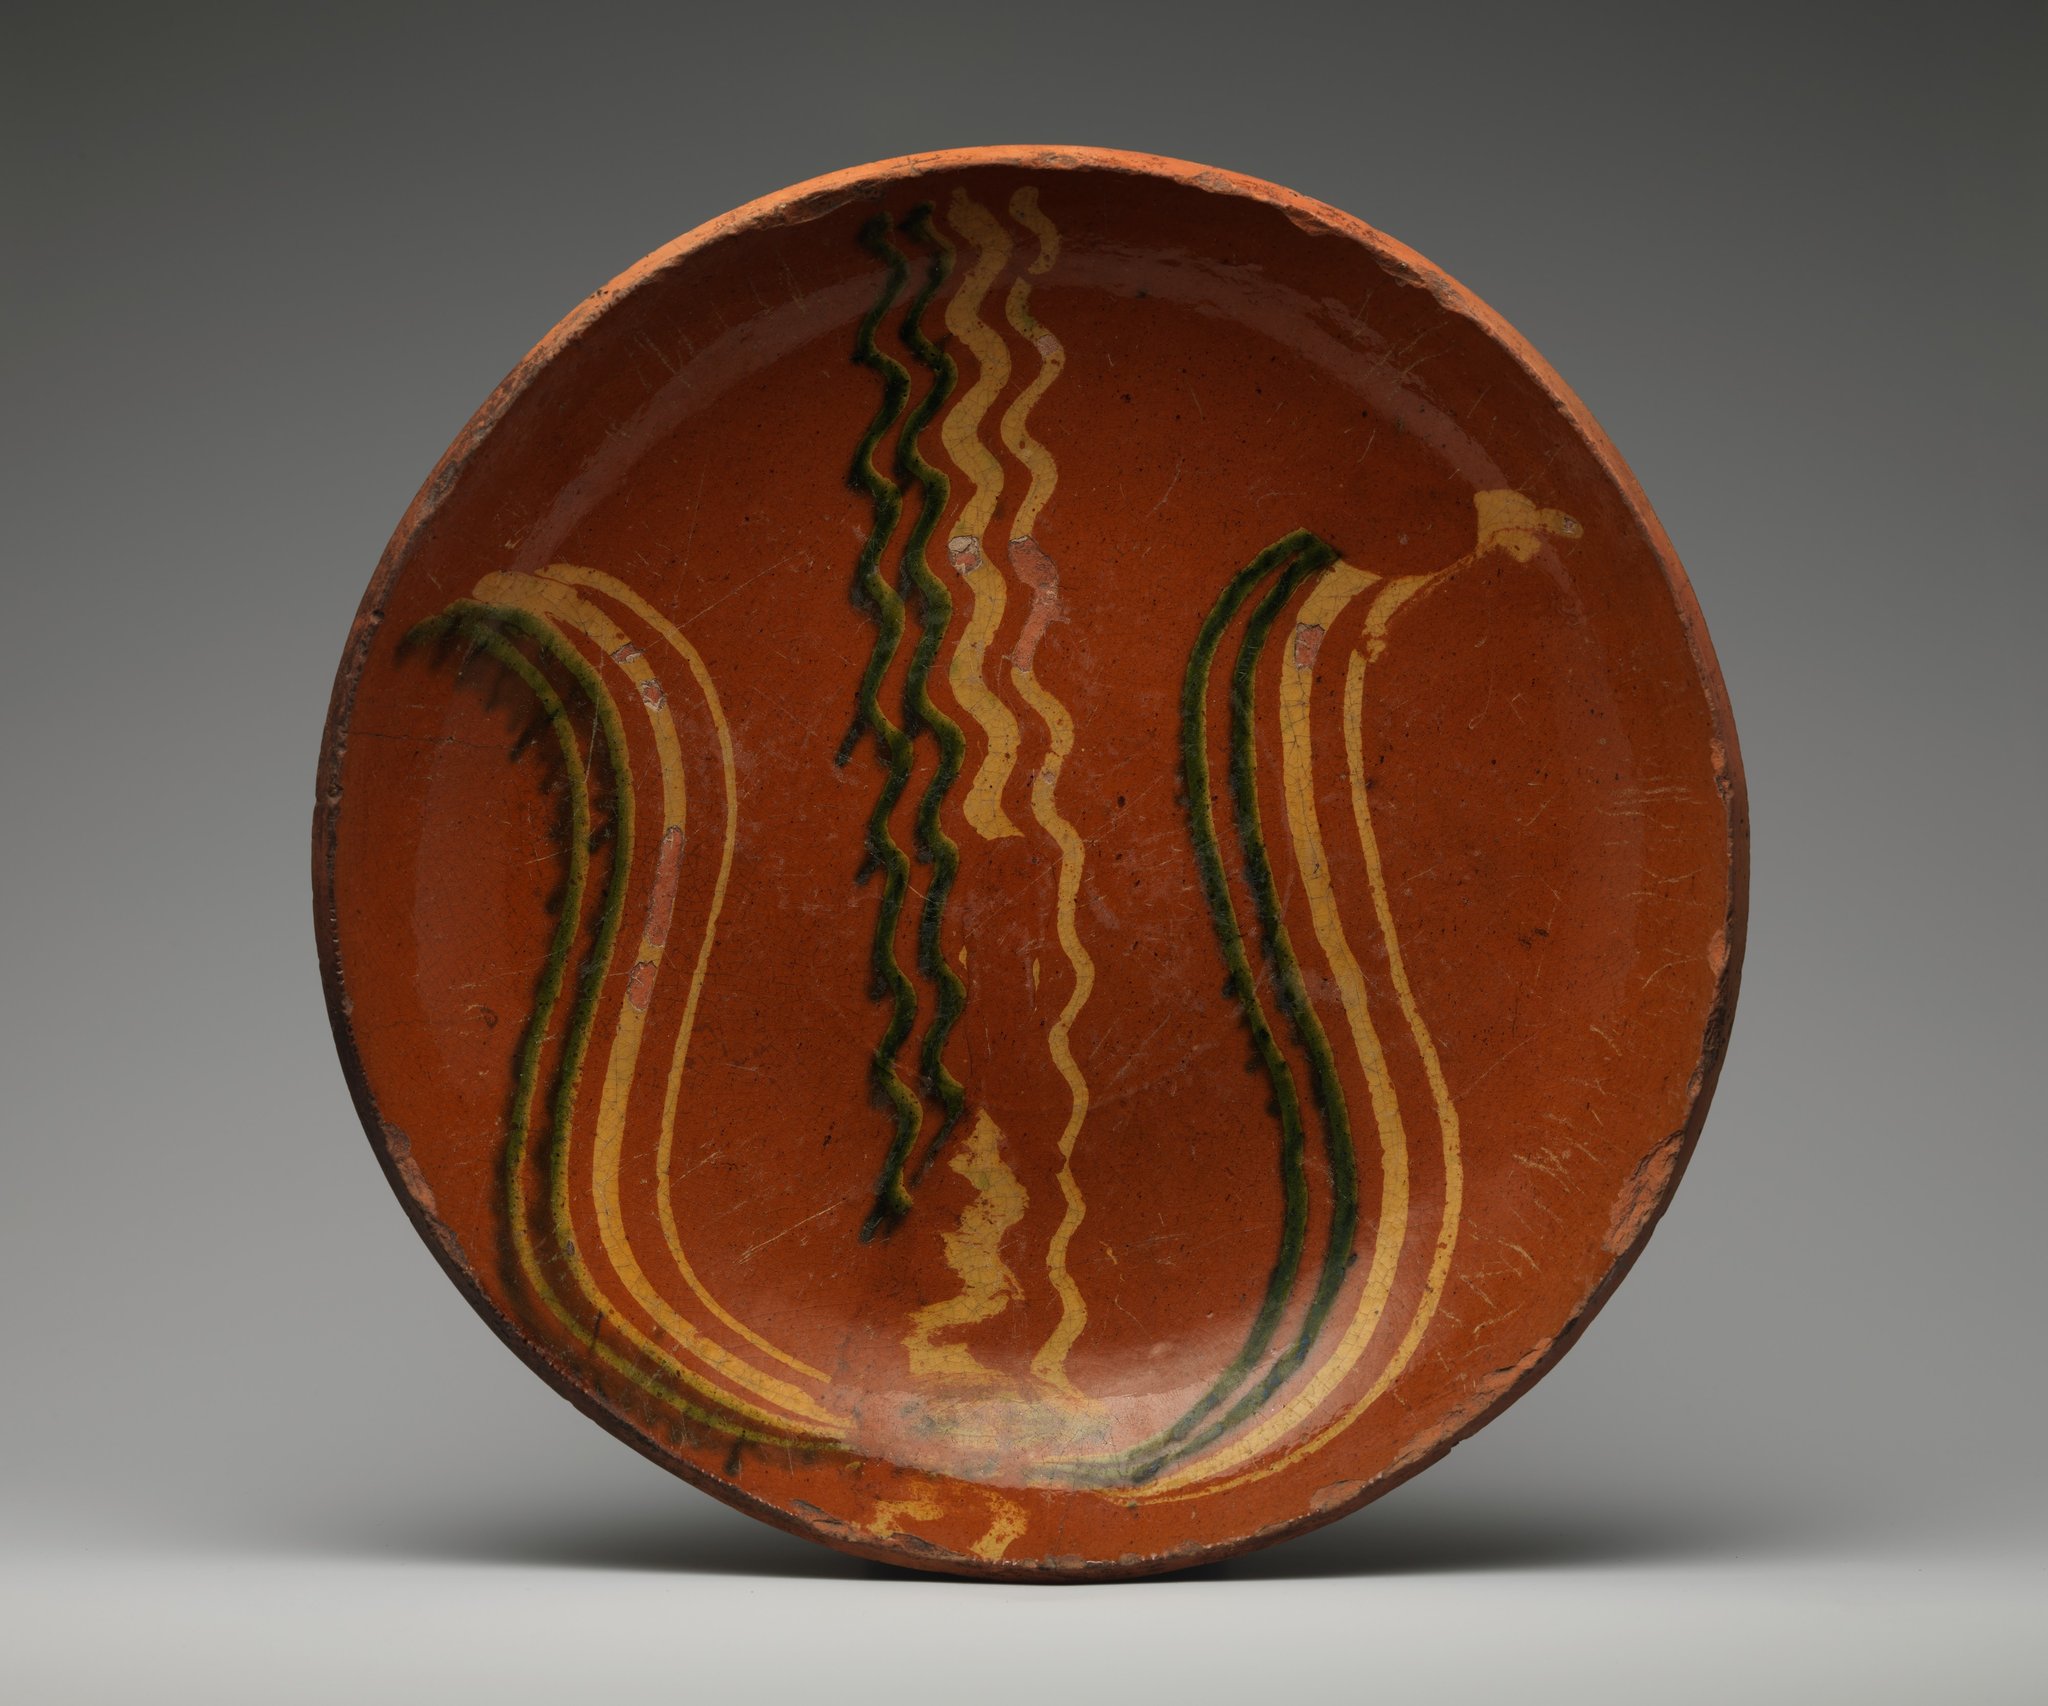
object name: plate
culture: american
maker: daniel dry , active ca. 1820-80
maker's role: artist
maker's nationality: american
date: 1820-1880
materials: earthenware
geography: united states